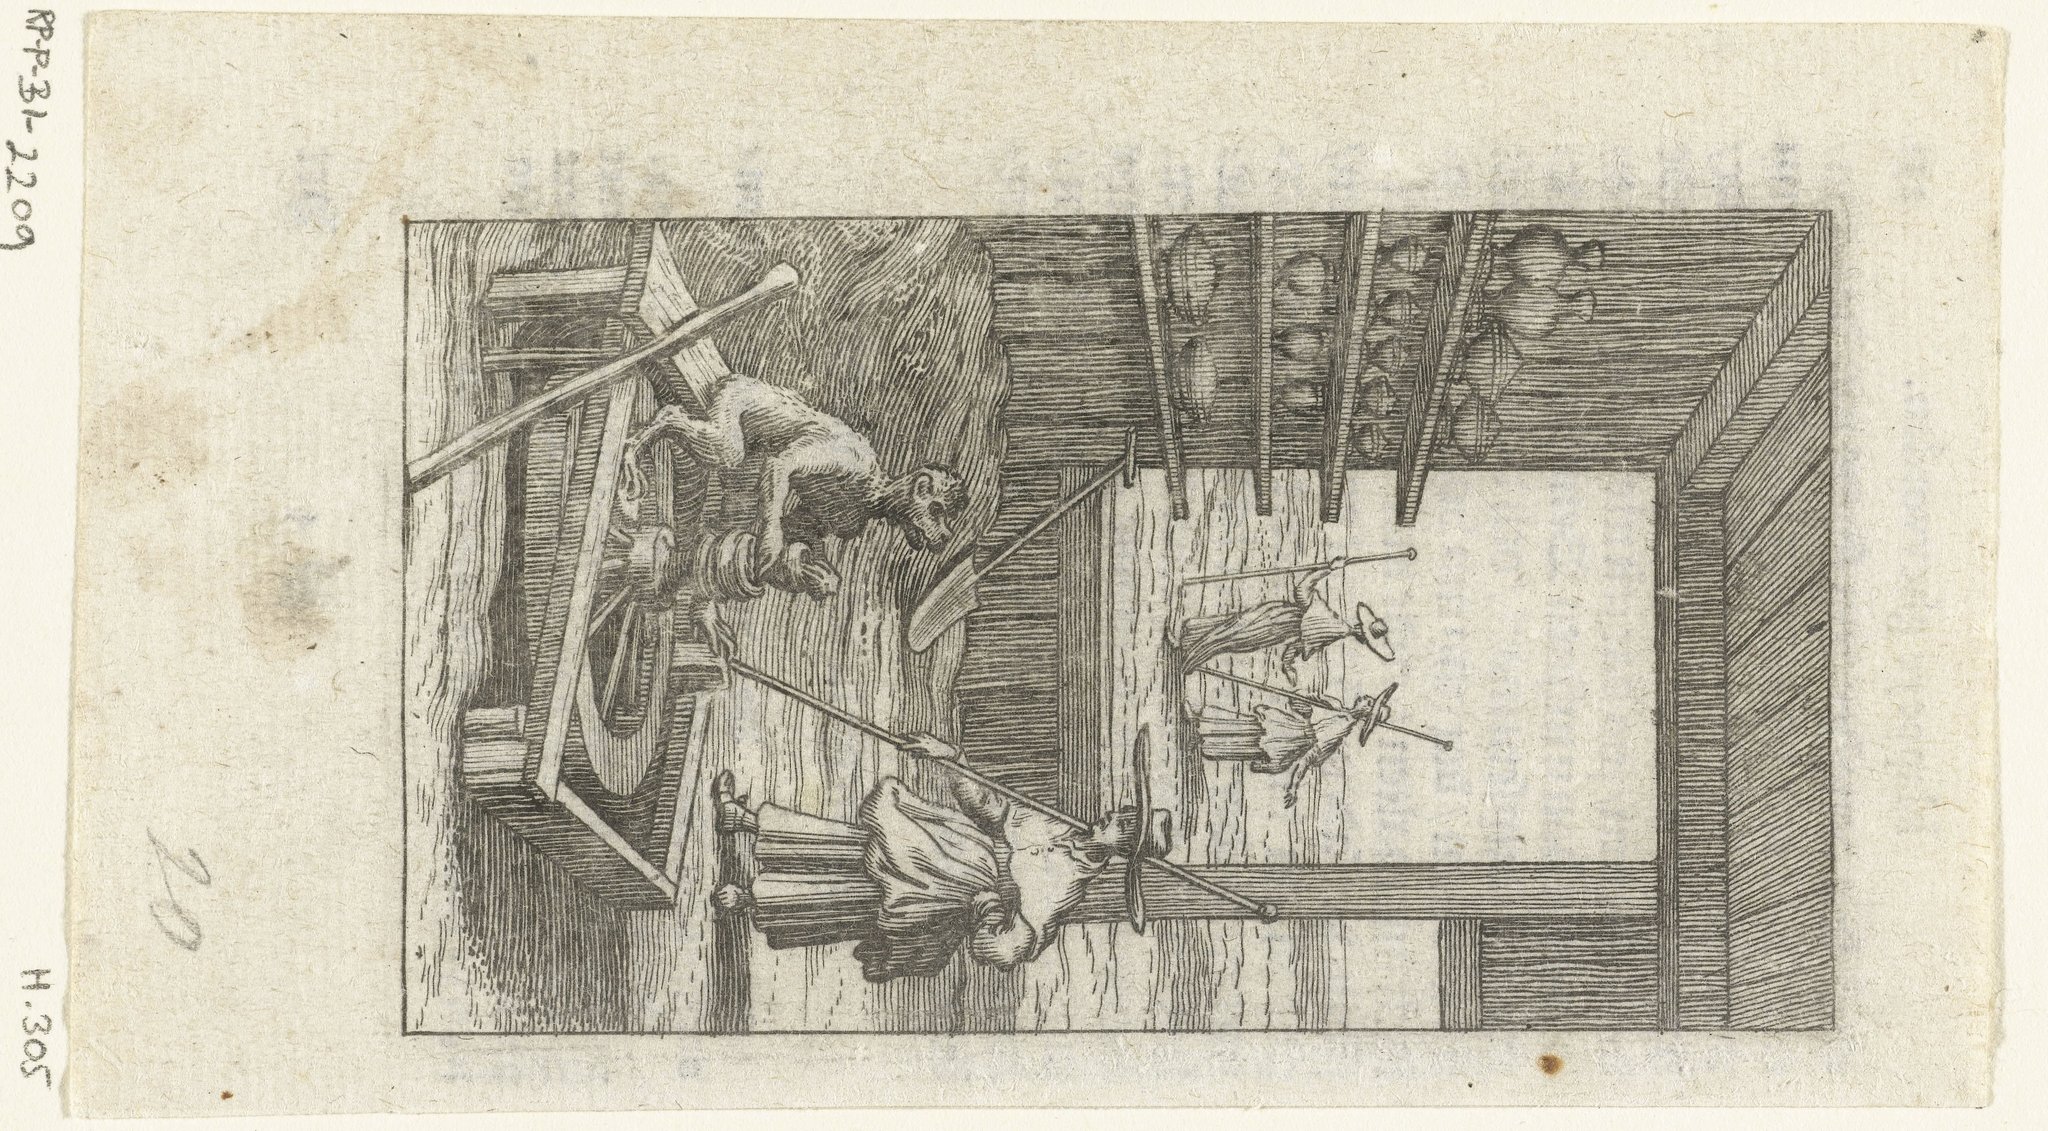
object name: book illustration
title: Willemynken in gesprek met aap als pottenbakker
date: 1590-1627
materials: paper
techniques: engraving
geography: antwerp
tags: monkeys, apes, animals tied up, animals acting as human beings, pilgrimage, pilgrim(s) under way, potter, ceramist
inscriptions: collector's mark: Lugt 2228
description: Prent uit: Boëtius Adamsz. Bolswert, Duyfkens en Willemynkens pelgrimagie tot haren beminden binnen Iervsalem. Haerlieder teghenspoet, belet en eynde, Antwerpen, Hendrick Aertssens, 1638. Op het verso staat een verklarende Nederlandse tekst bij de voorgaande illustratie in dit devotie boekje (vergelijk RP-P-BI-2208).